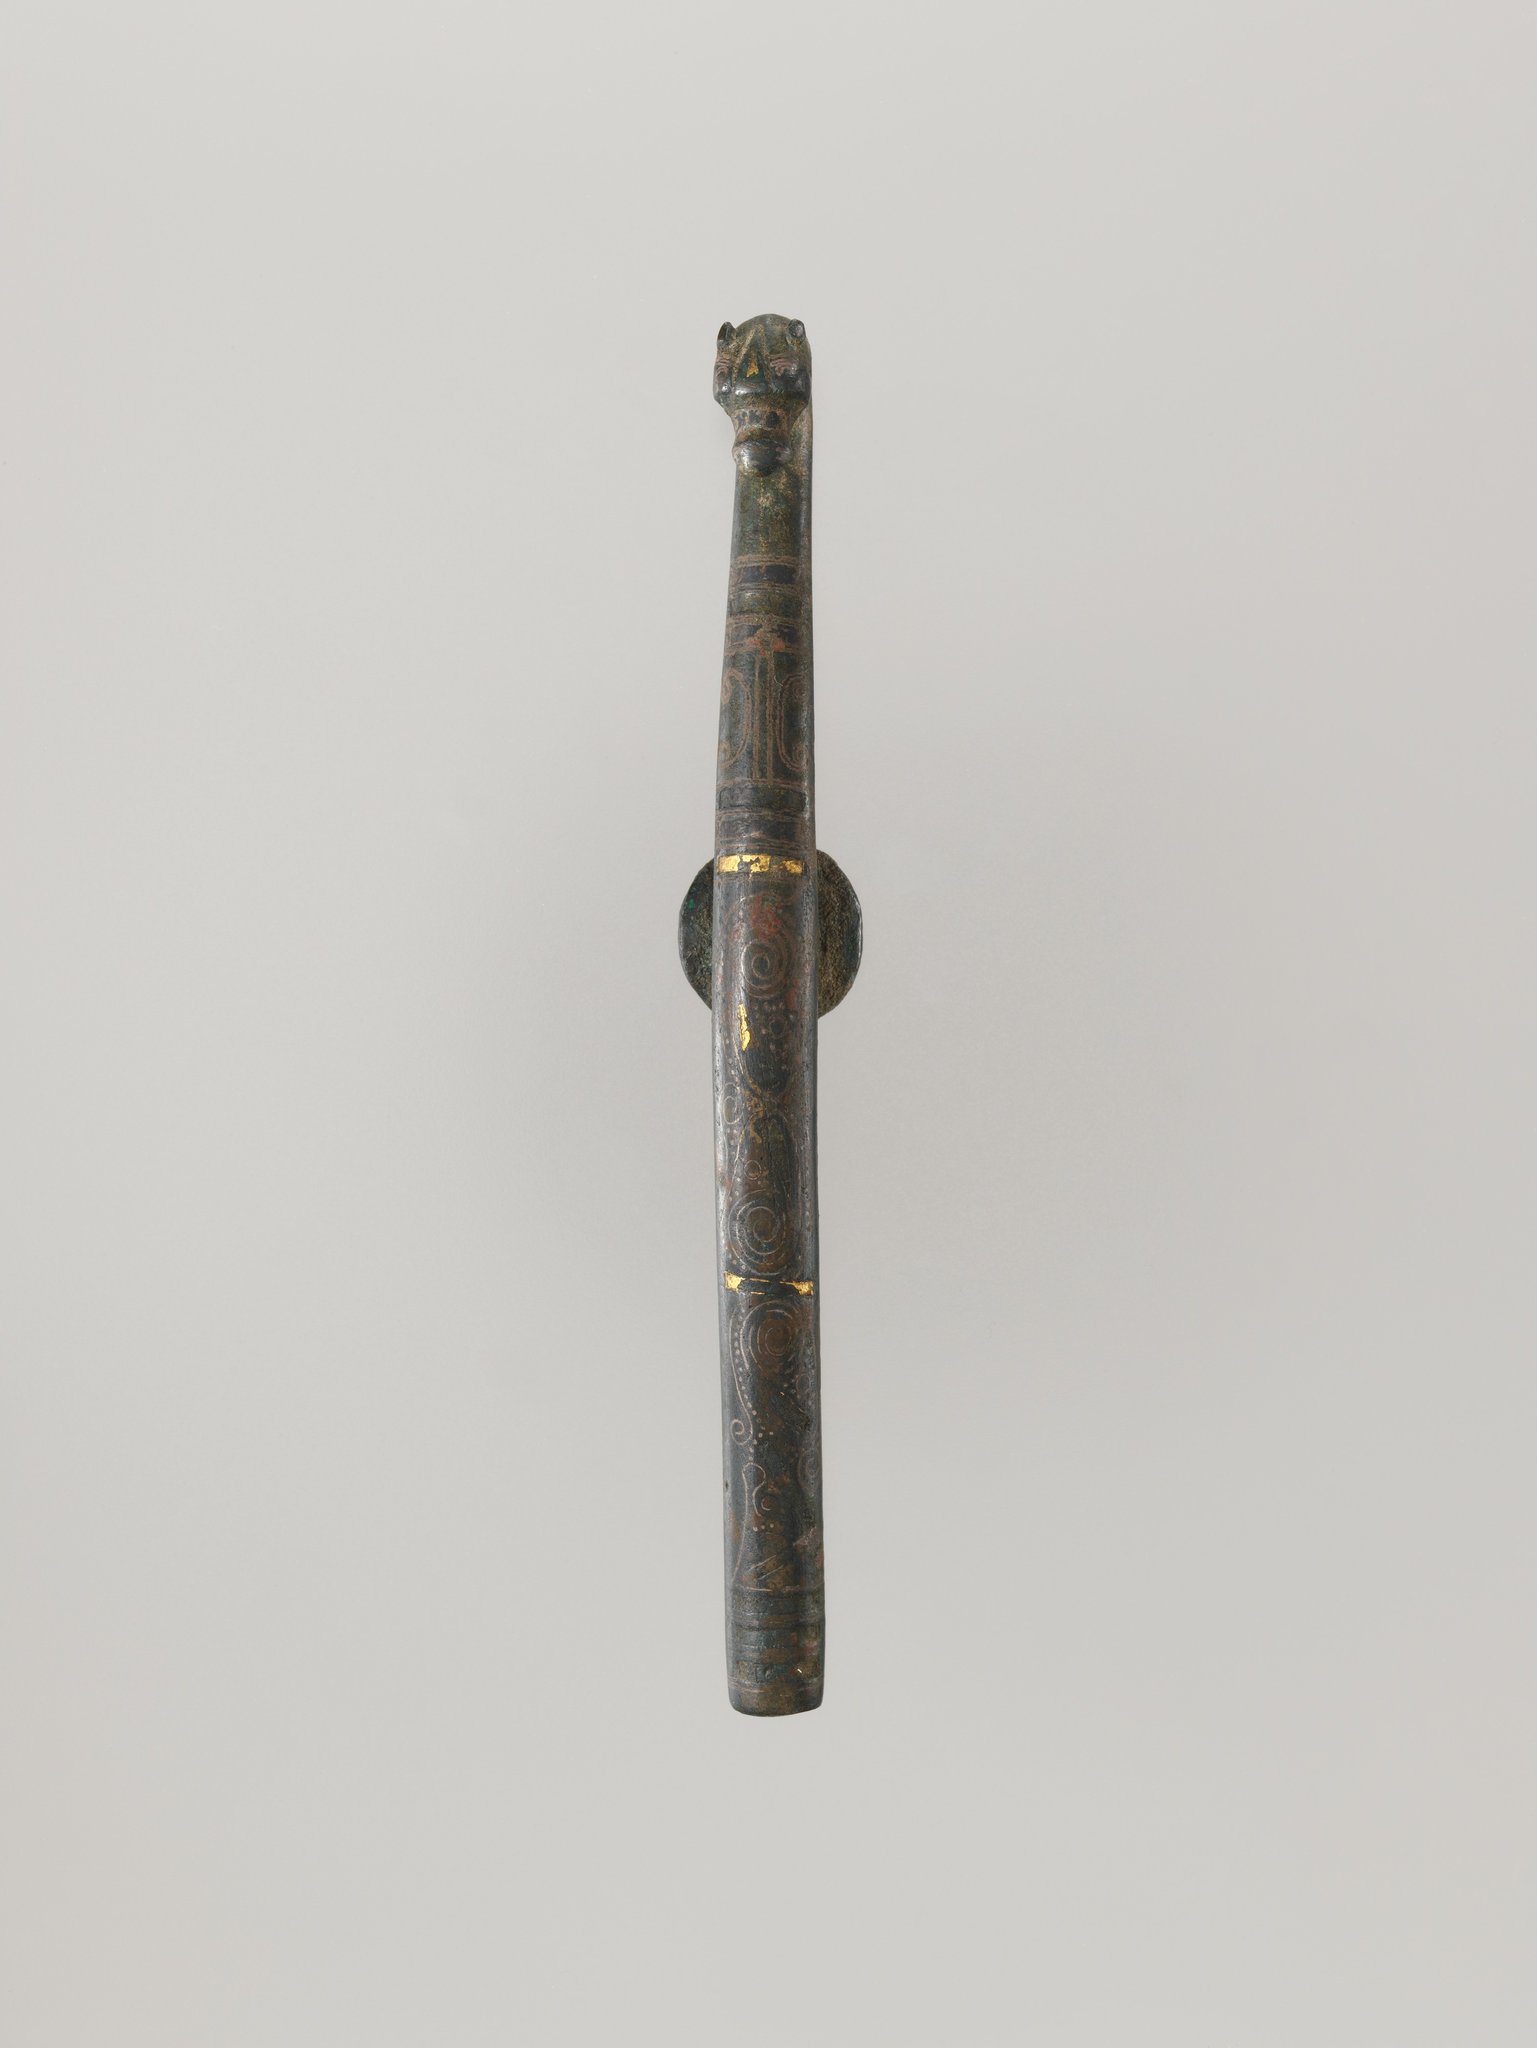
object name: belt hook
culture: chinese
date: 215-316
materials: bronze